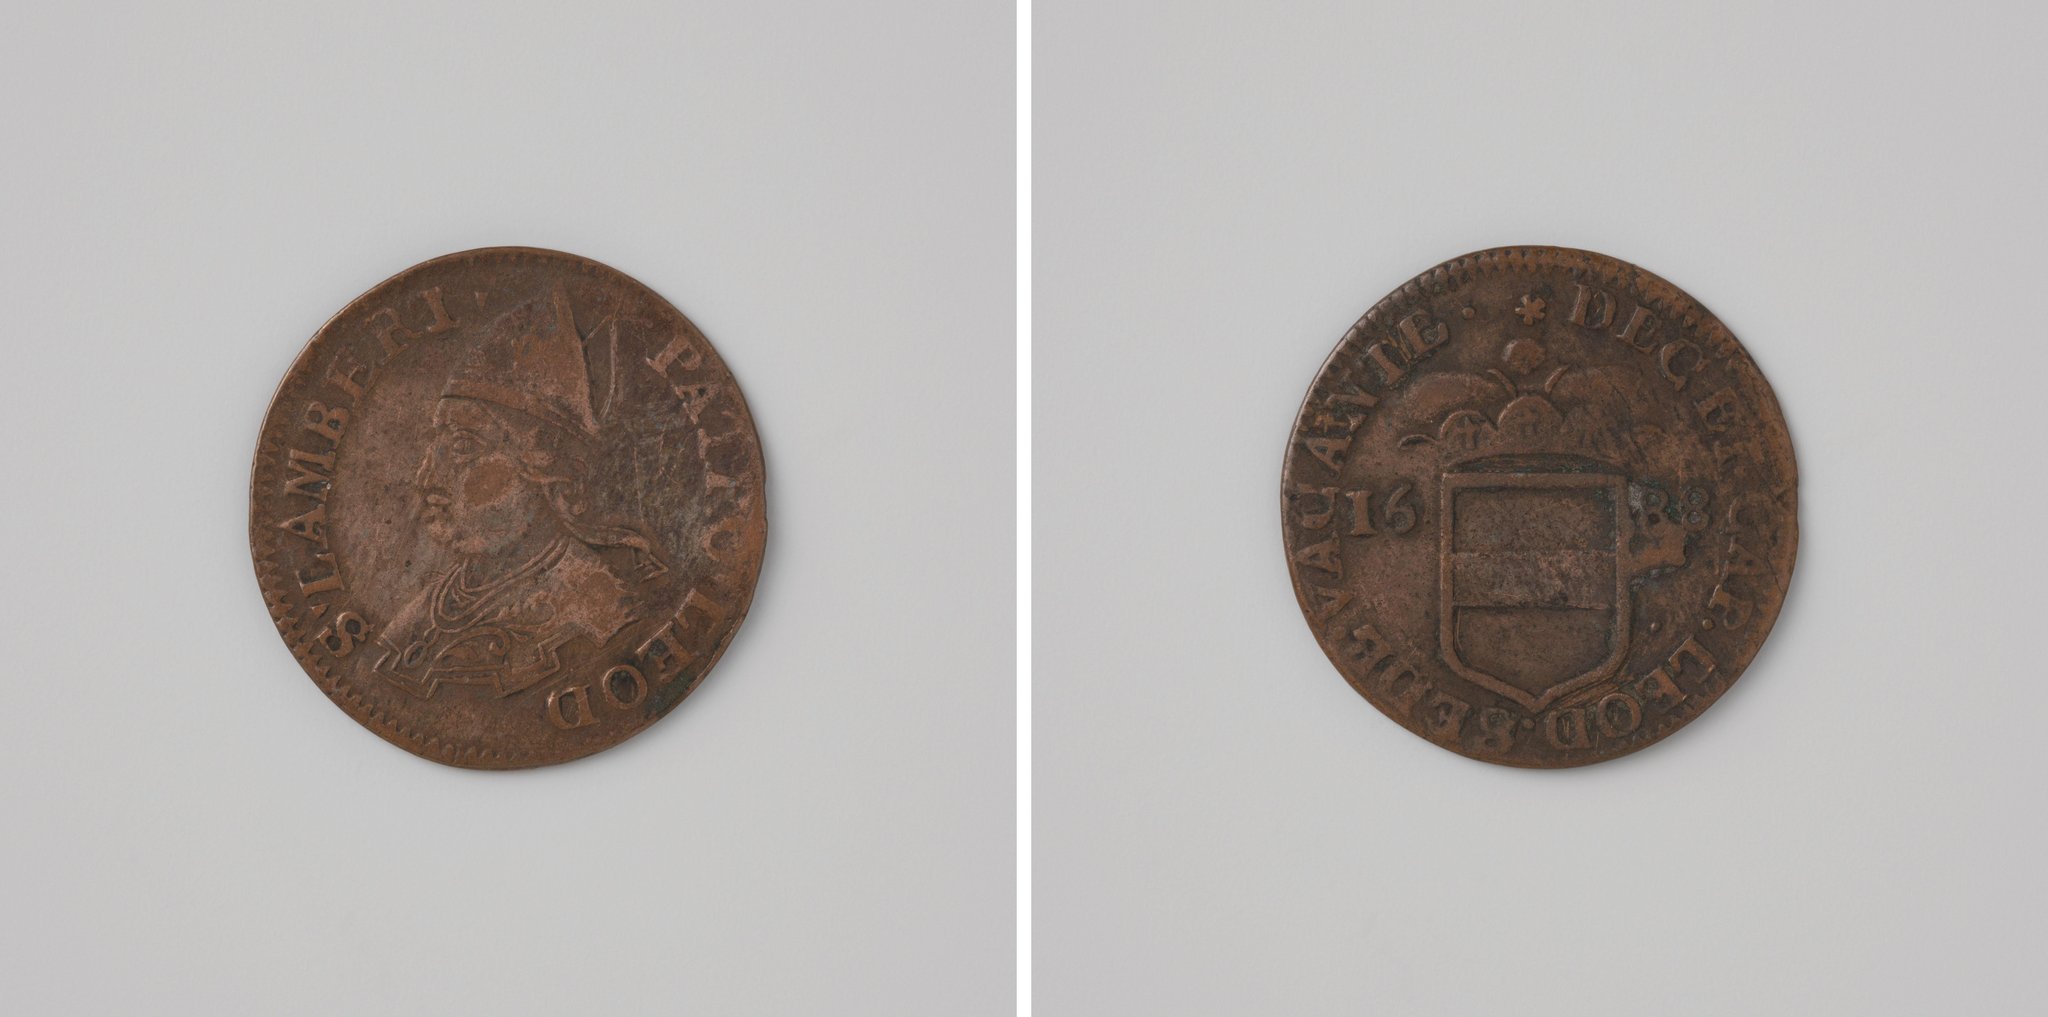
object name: coin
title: Munt van kwart stuiver van de bisschopszetel van Luik vacant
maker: Anonymous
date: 1688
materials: bronze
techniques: striking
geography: liège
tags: liège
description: Voorzijde: borststuk man met mijter binnen omschrift. Keerzijde: gekroond wapenschild tussen jaartal binnen omschrift